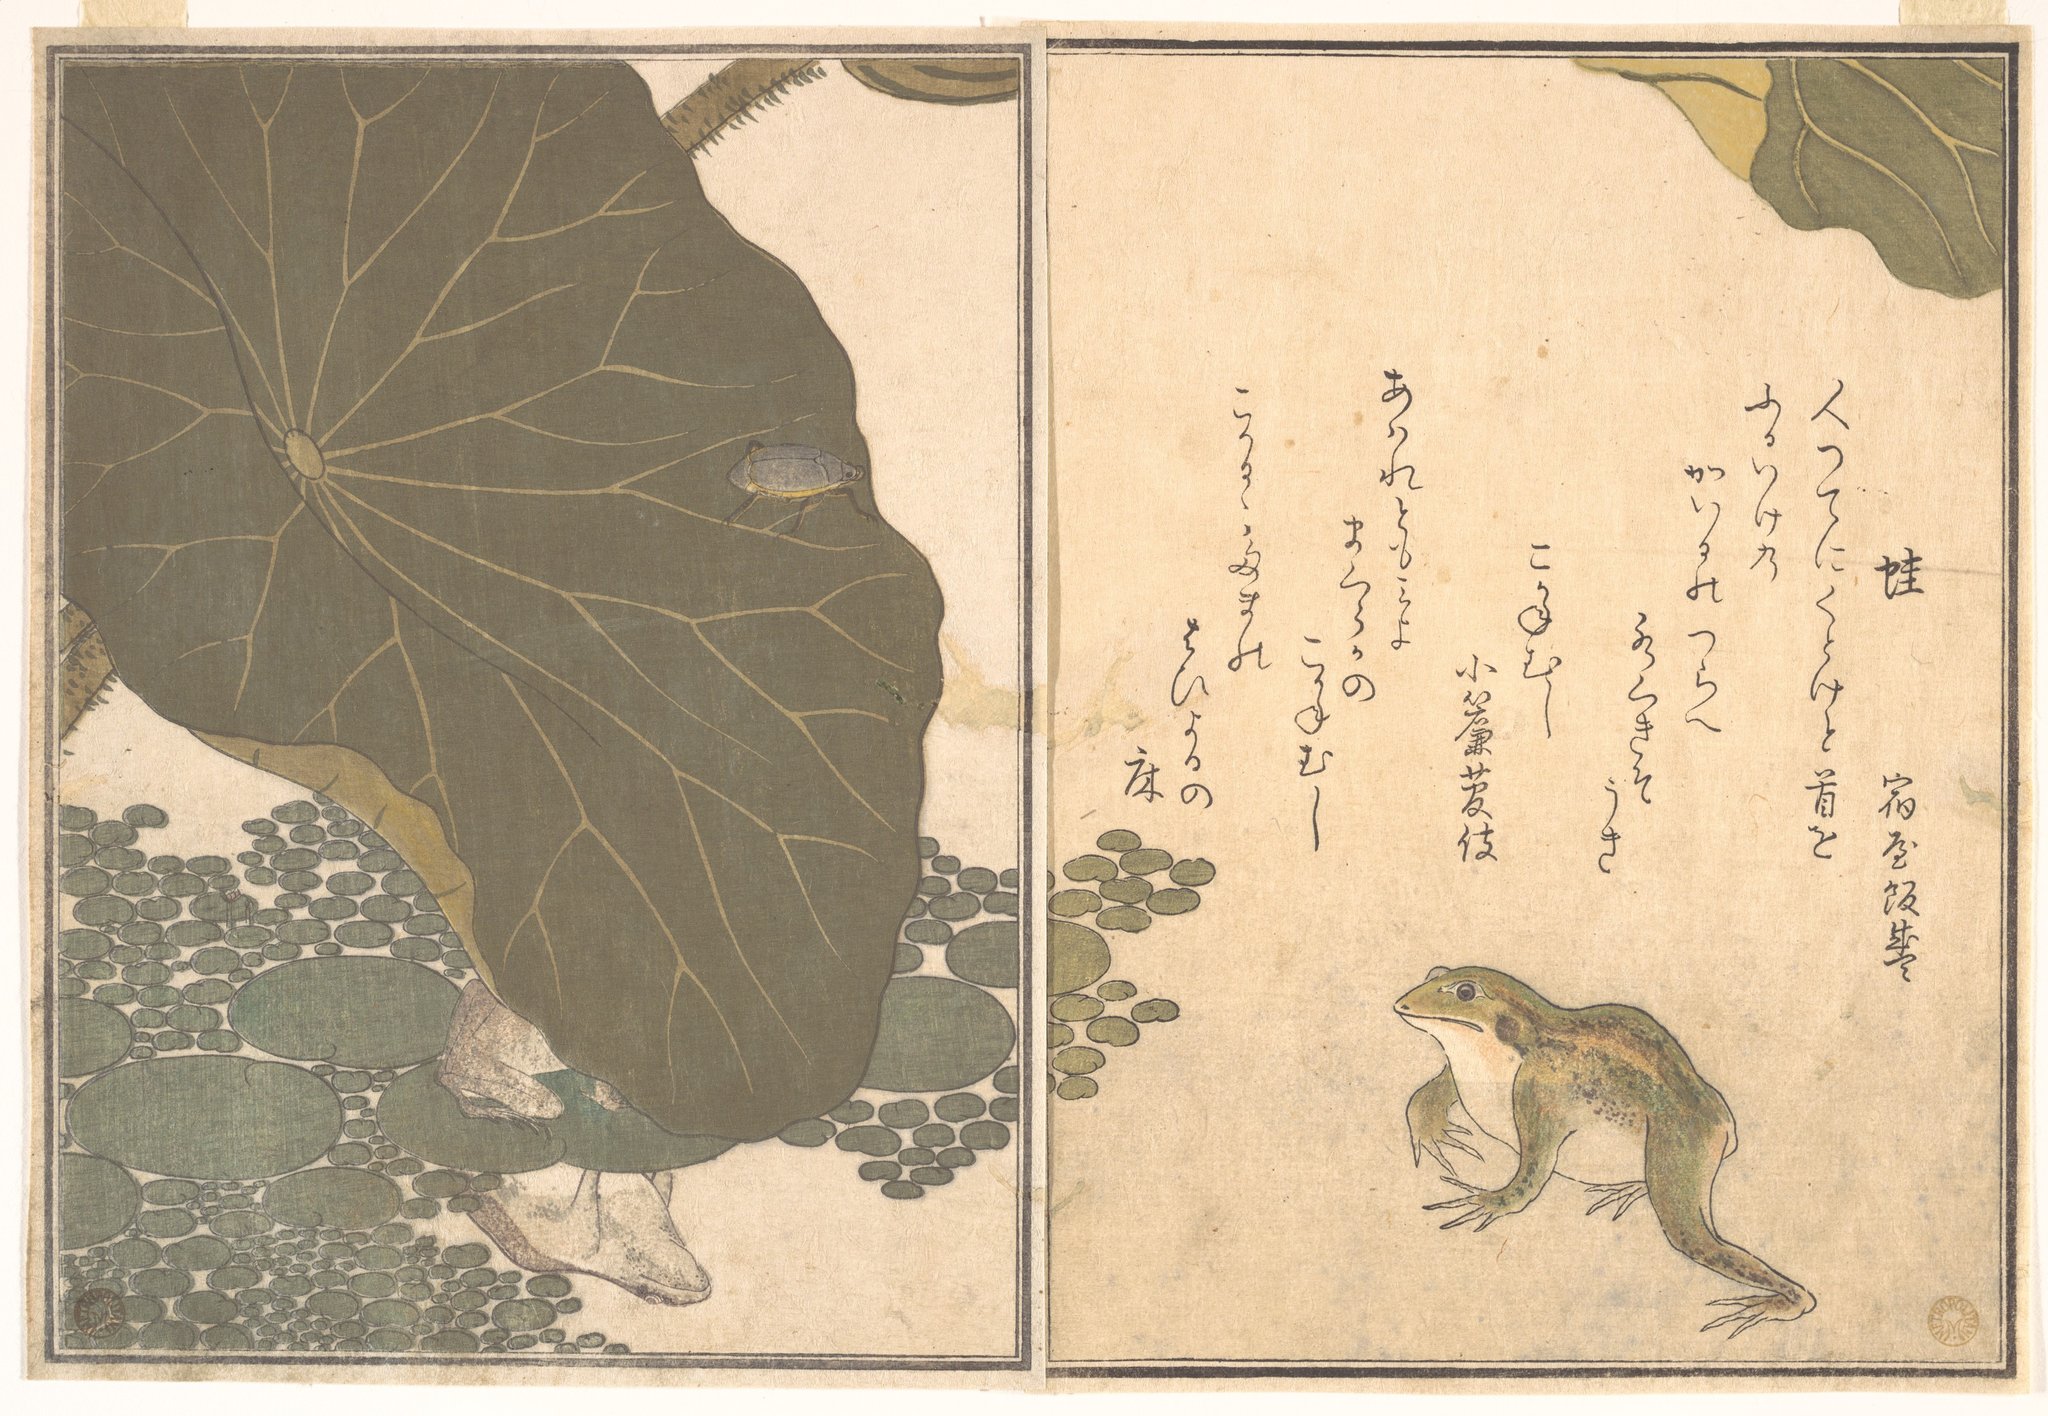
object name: woodblock print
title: Frog (Kaeru); Gold Beetle (Kogane mushi), from the Picture Book of Crawling Creatures (Ehon mushi erami)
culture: japanese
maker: kitagawa utamaro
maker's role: artist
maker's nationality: japanese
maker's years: 1754-1806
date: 1788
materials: ink, paper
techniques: woodblock print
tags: frogs,insects